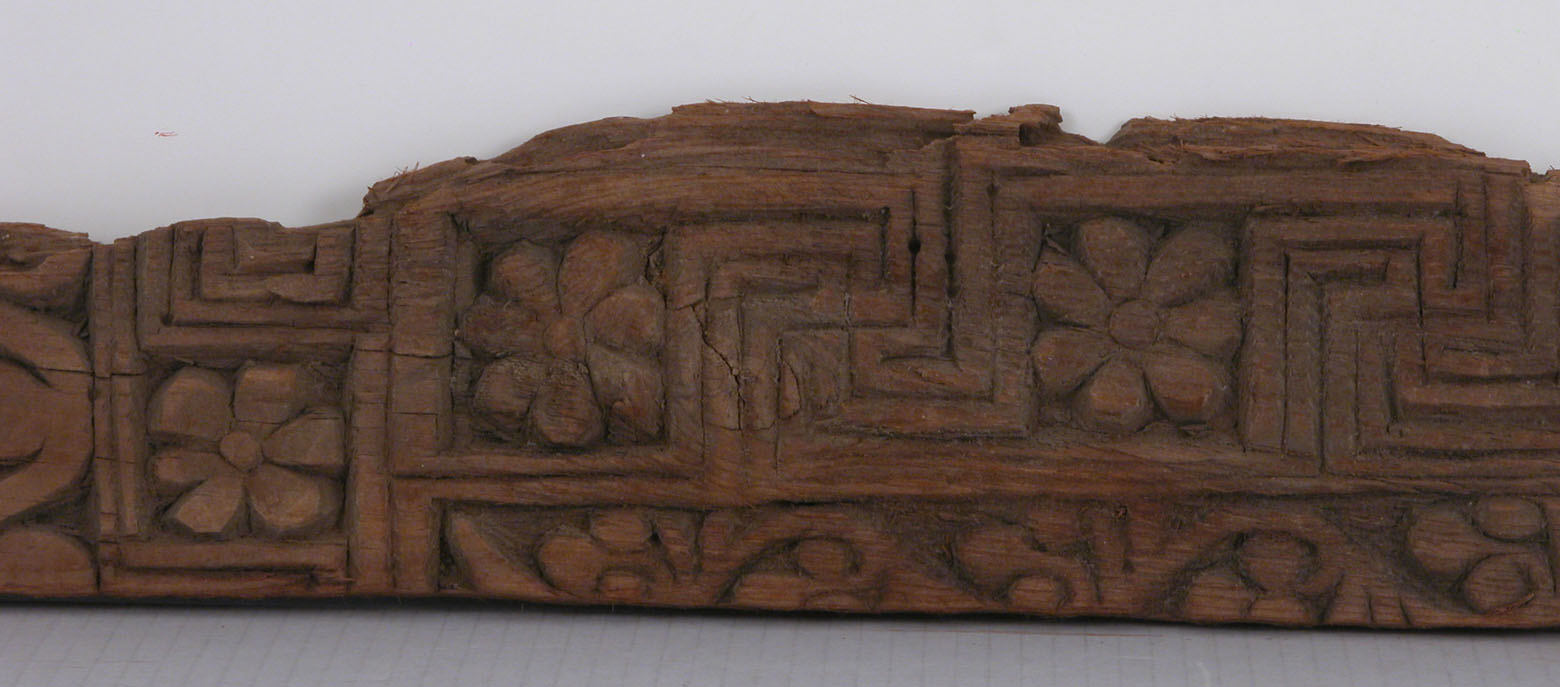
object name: fragment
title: Fragment of a Panel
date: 501-700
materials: wood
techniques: carving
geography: egypt